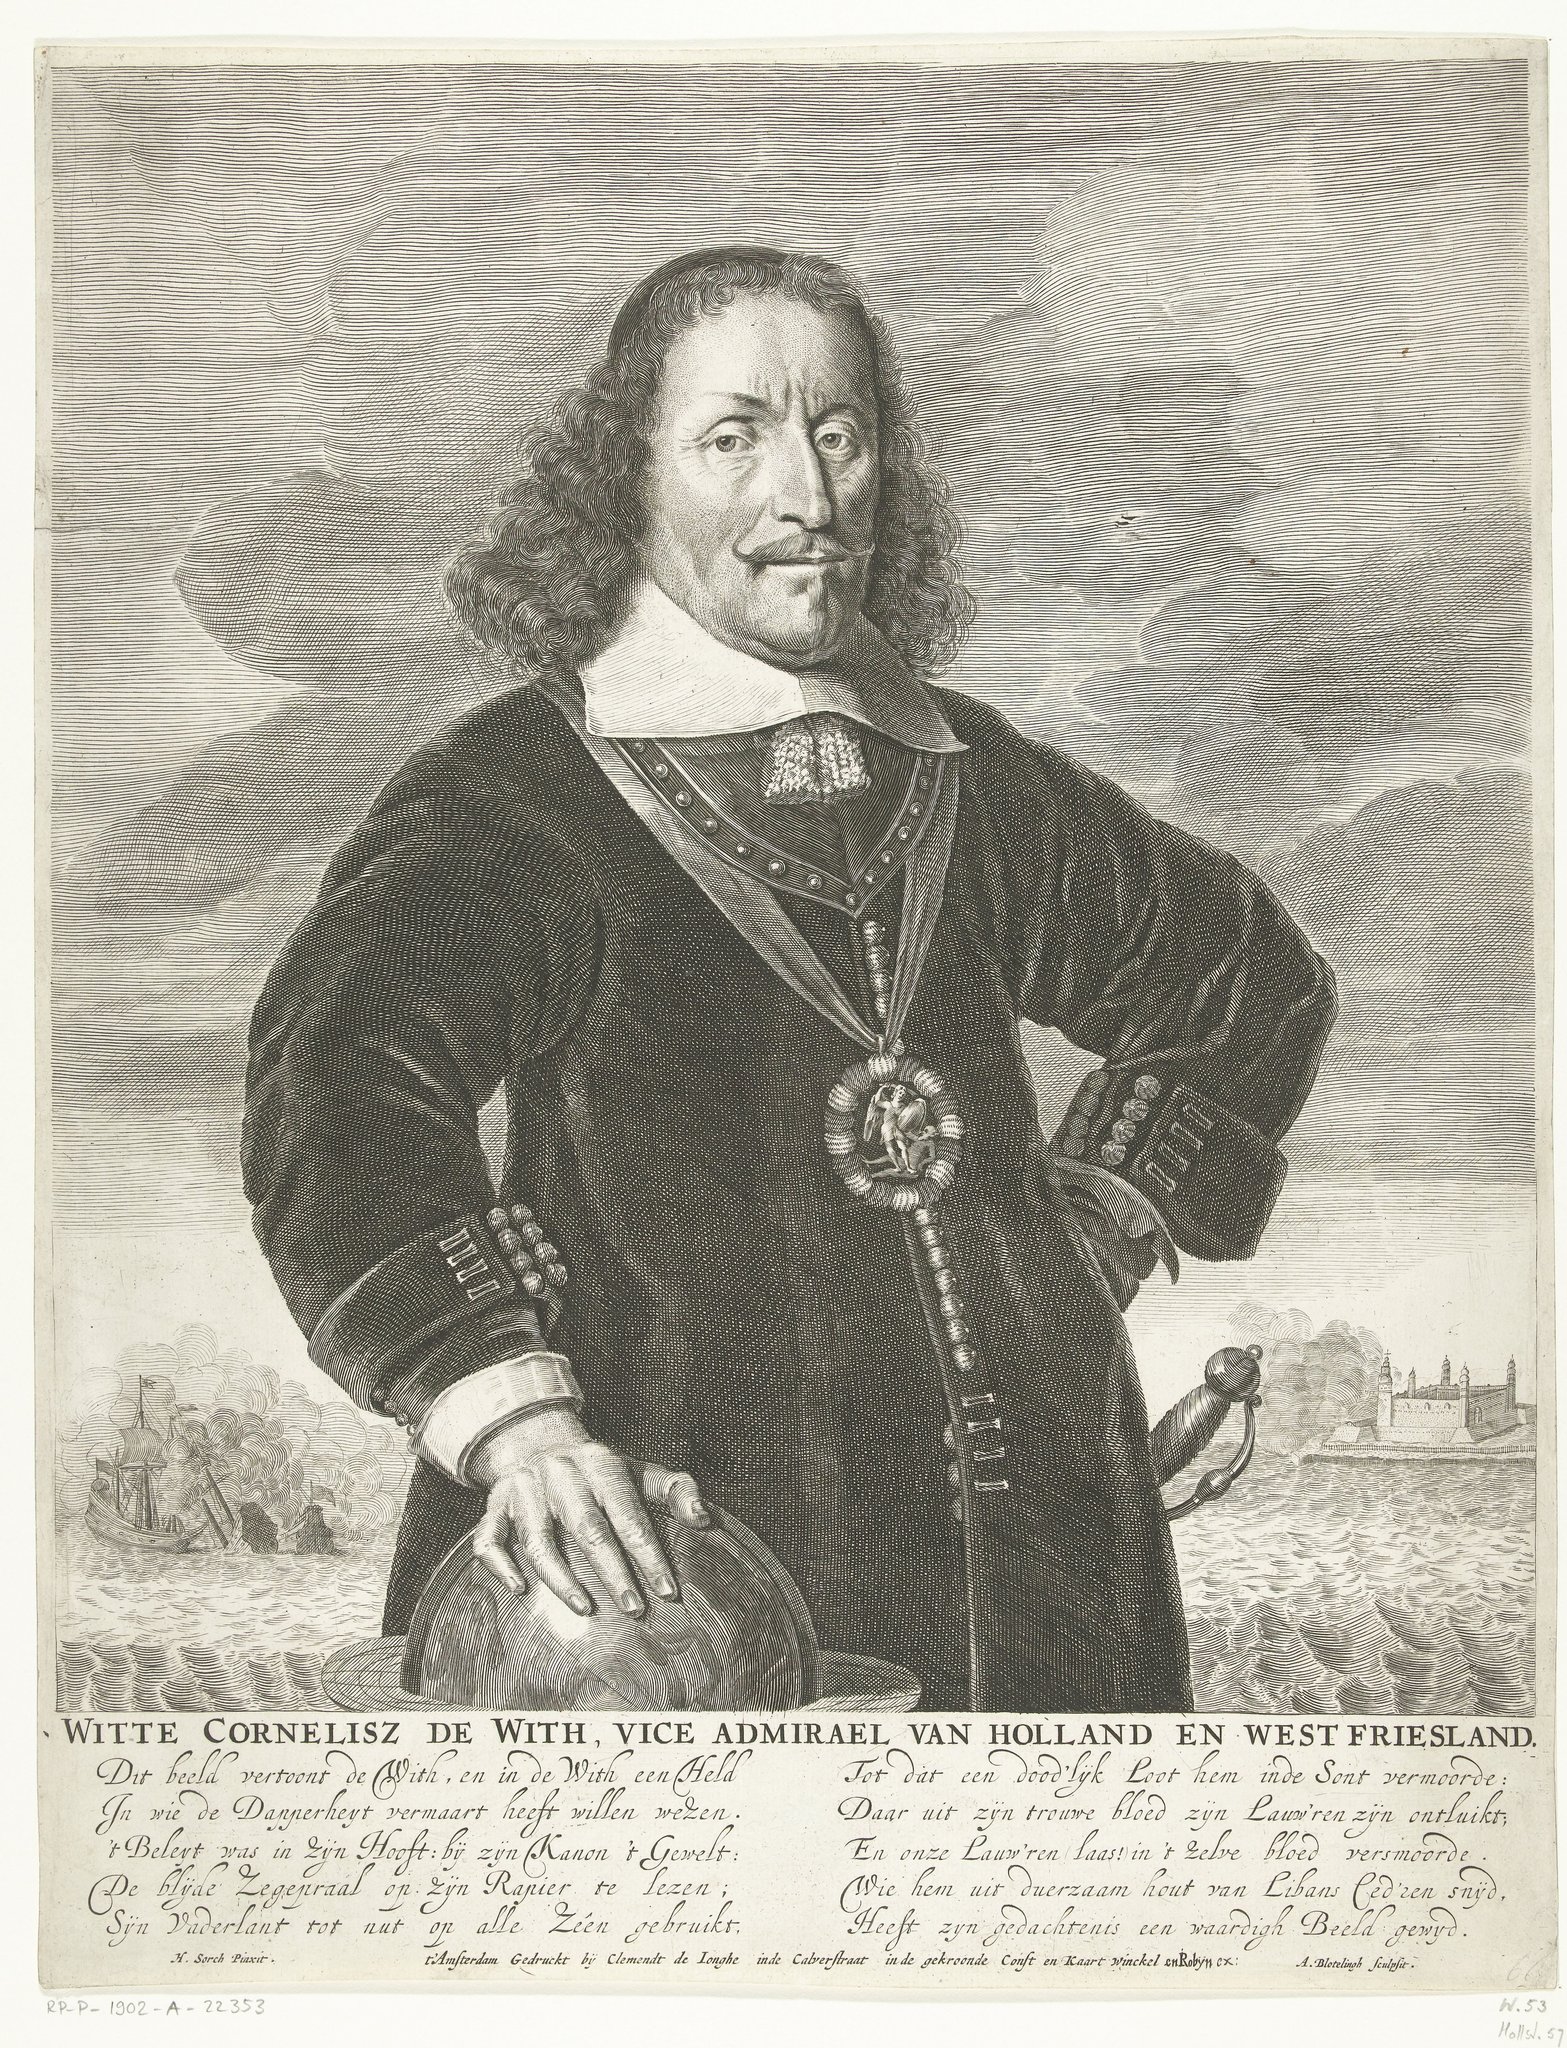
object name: print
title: Portret van Witte Cornelisz de With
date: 1658-1690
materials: paper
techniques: engraving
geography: amsterdam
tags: hoogendijk, zeeofficier, witte cornelisz. de with, orde van saint michel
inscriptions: collector's mark: Lugt 2228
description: Portret van de marineadmiraal Witte Cornelisz. de With, staand bij een globe. Op de achtergrond is rechts een fort te zien, links is een zeeslag bezig. De With draagt om zijn nek een medaillon met een engel die een duivel verslaat, het draagteken van de Orde van Saint Michel, waarvan ook Michiel de Ruyter lid was.